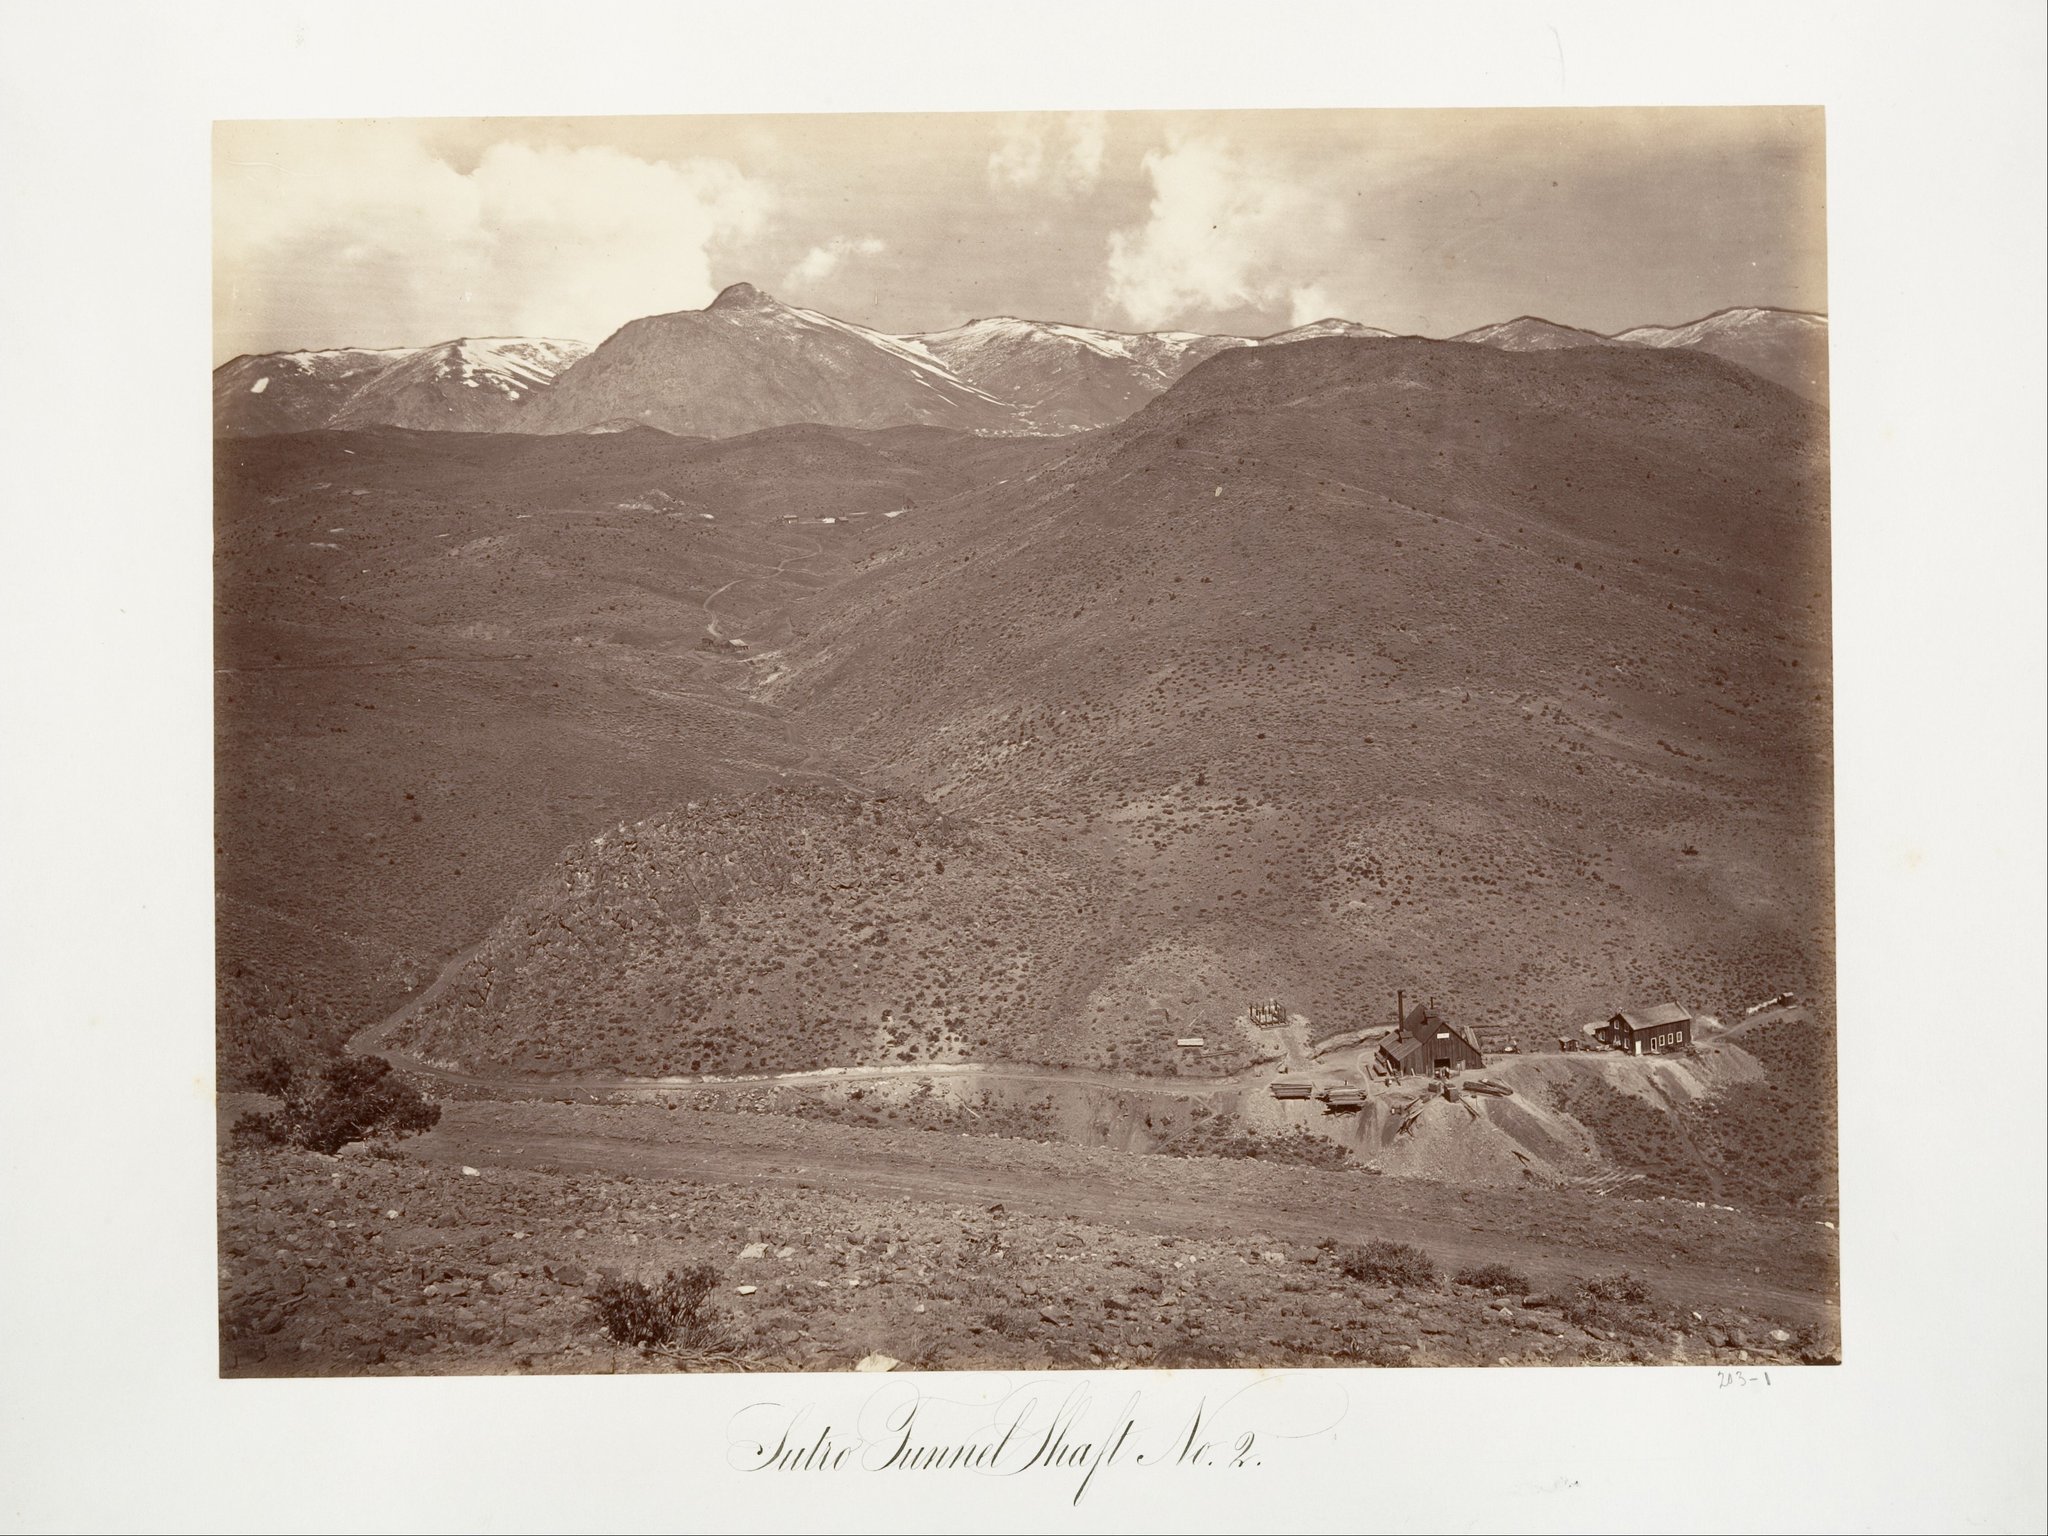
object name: photograph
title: Sutro Tunnel Shaft No. 2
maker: carleton e. watkins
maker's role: artist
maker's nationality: american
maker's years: 1829-1916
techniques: albumen silver print, glass negative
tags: mountains,landscapes